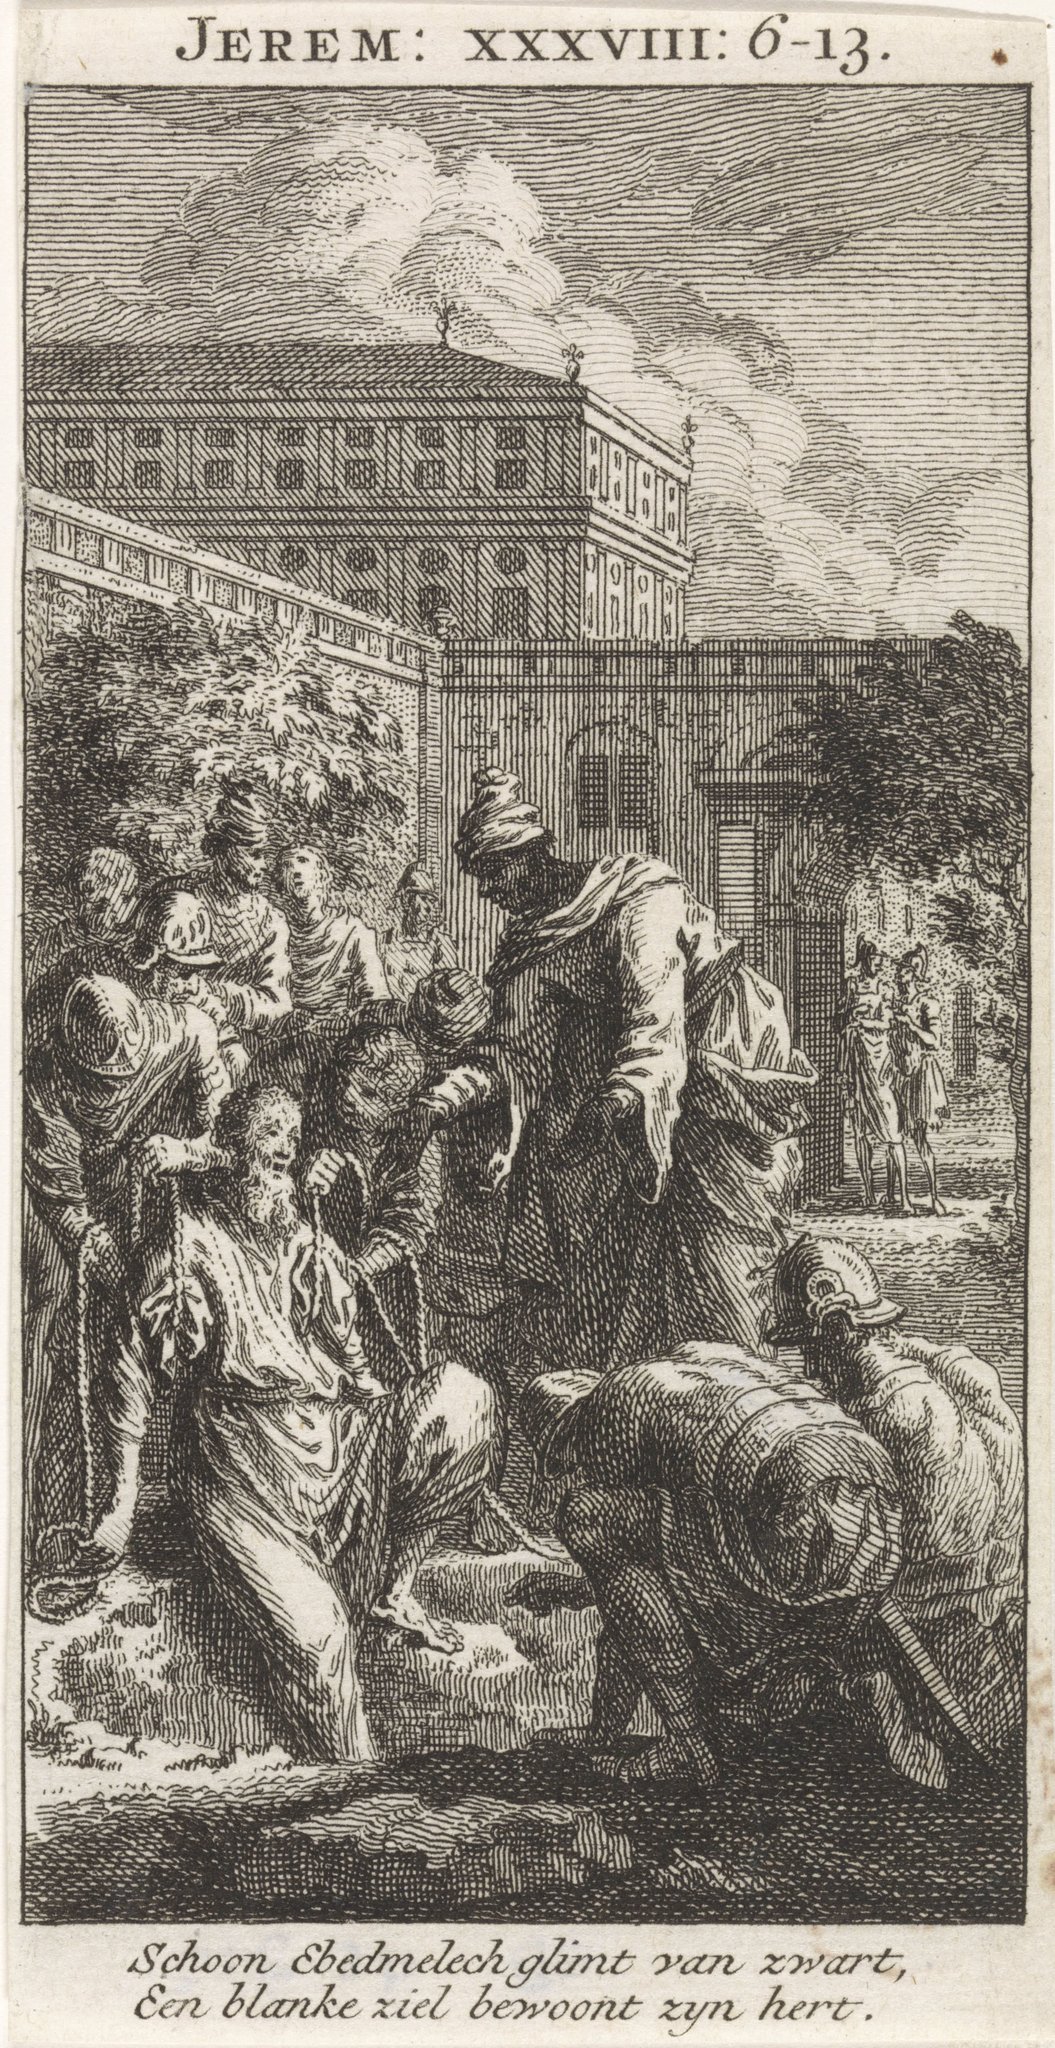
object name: print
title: Jeremia uit de kuil getrokken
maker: Anonymous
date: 1712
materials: paper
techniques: etching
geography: amsterdam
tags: jeremiah is released from the dungeon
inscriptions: collector's mark: Lugt 240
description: Kopie van illustratie voor: Luyken, Jan. Bybel printen. Amsterdam: Pieter Arentsz. II (wed.) en Cornelis van der Sys, 1712, p. 15.